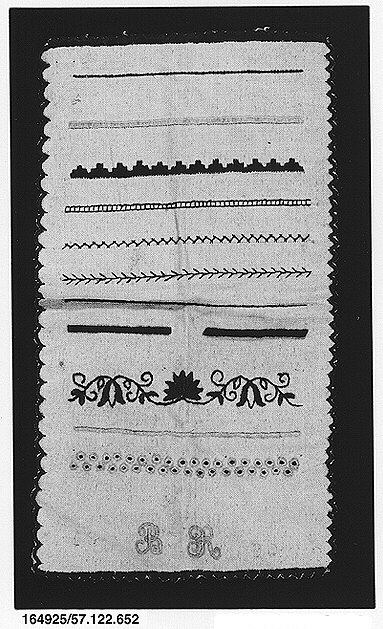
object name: sampler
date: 1801-1900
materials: cotton, linen